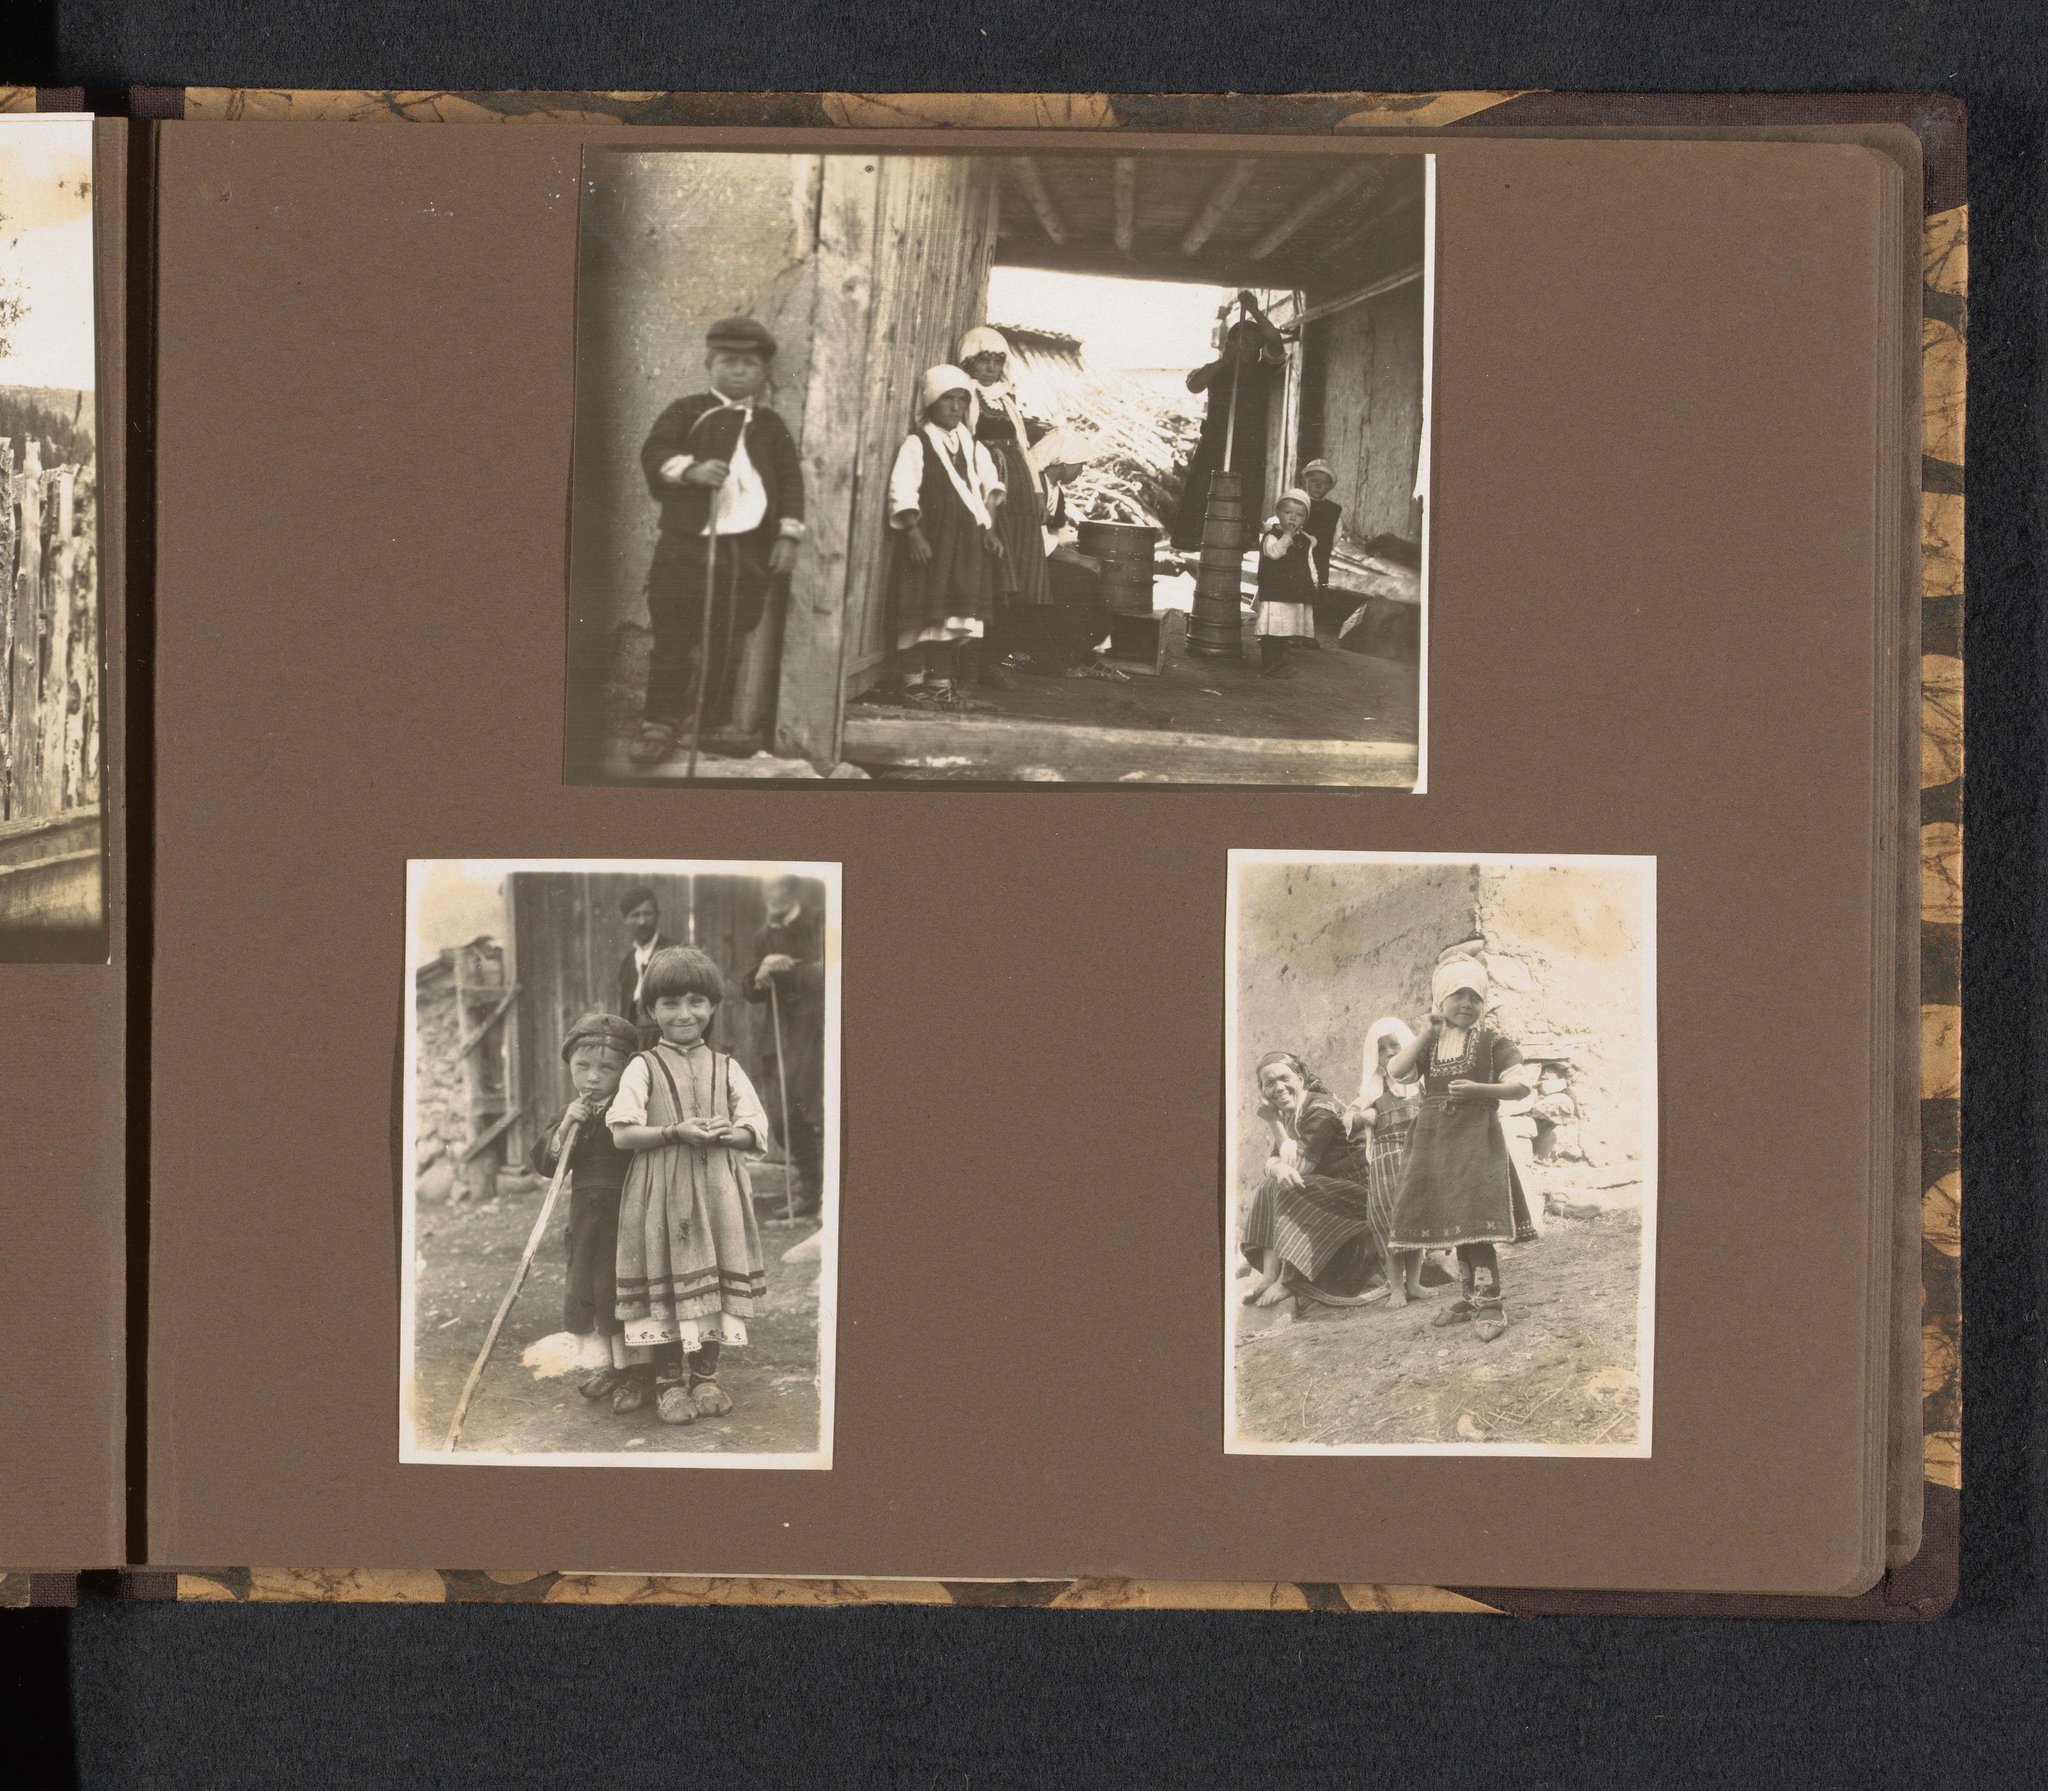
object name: photograph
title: Bulgaarse kinderen en volwassenen in een Bulgaars dorp tijdens een rondreis van Else Wachenheimer-Moos en haar echtgenoot Eugen Wachenheimer, 1926-1927, Bulgarije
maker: else wachenheimer-moos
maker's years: 1895-1944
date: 1926-1927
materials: paper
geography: bulgaria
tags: bulgarije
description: Albumblad bevat drie foto's. Zonder personen gerelateerd aan de familie Wachenheimer. Afkomstig uit album half formaat, kartonomslag met koordbinding en lichte veelvormige vormen op voorzijde.